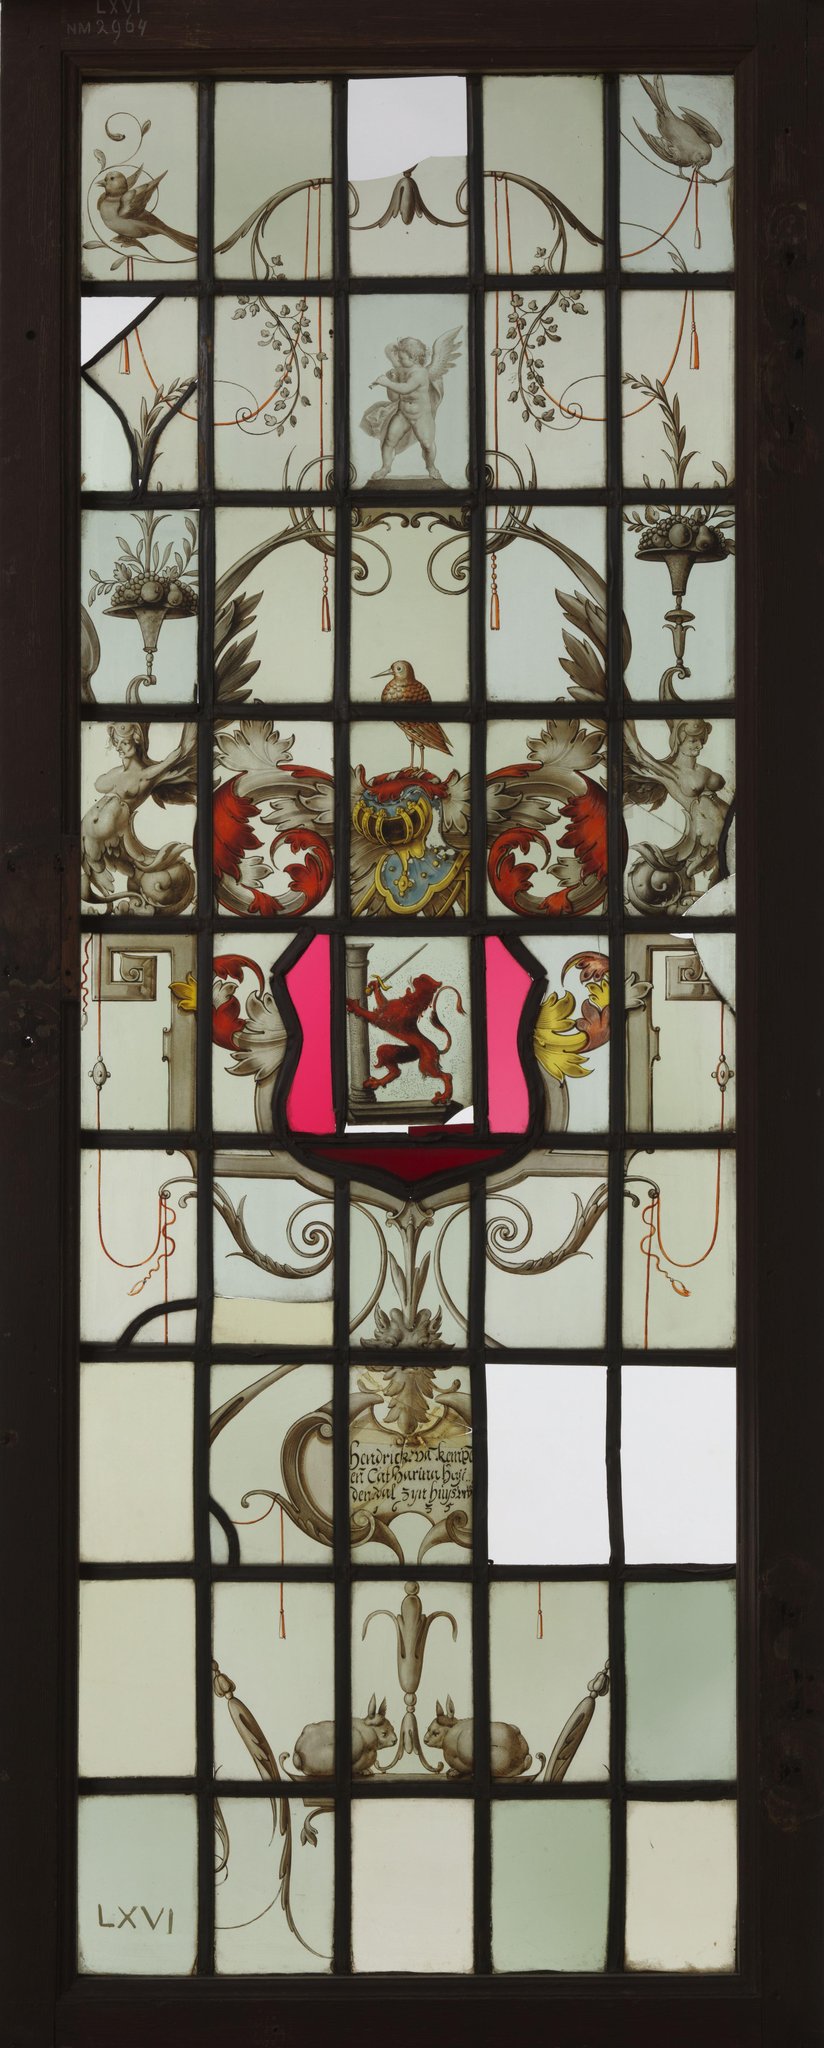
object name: light window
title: Ruit met wapen en onderschrift "Hendrick van Kempe en Catharina Heyendal zijn huysvrou 1635"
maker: Anonymous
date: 1635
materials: glass, lead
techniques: leading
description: Hoog, smal raam met het wapen van Hendrick van Kempe en Catharina Heyendal zijn huysvrou. 1635. Ruit zit in oud houten raam zonder hang- en sluitwerk. Opmerking: Hoort bij inv. nr. BK-NM-2963.